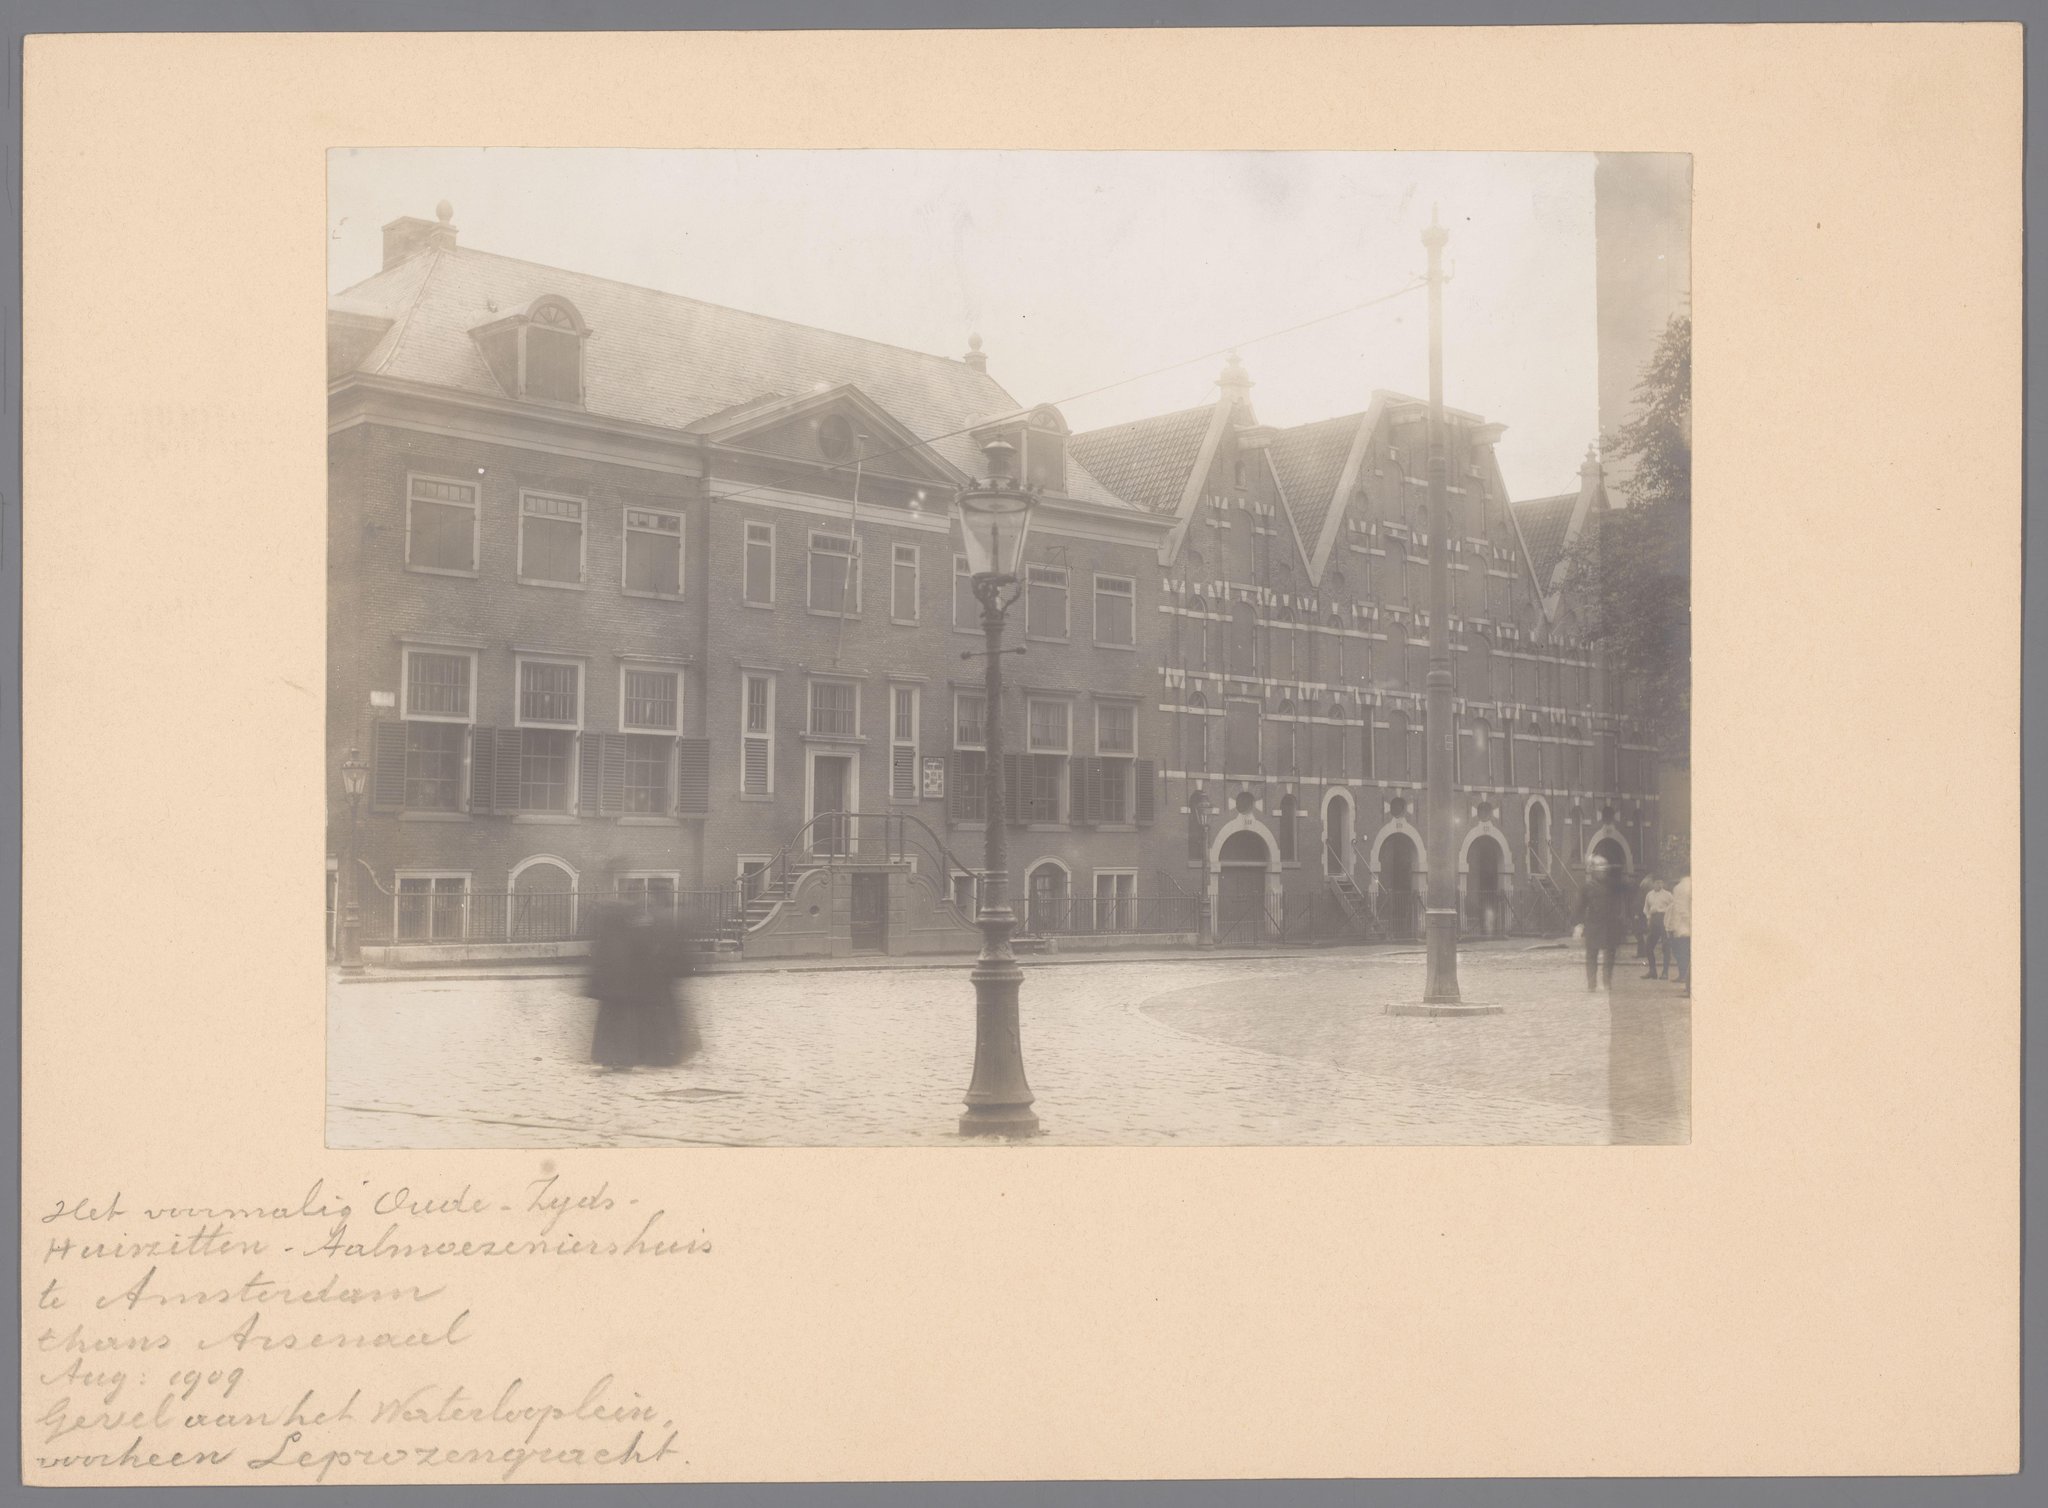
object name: photograph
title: Gezicht op het Arsenaal of de stadsturfpakhuizen te Amsterdam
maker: anoniem (monumentenzorg)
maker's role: fotograaf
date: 1909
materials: cardboard, photographic support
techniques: gelatin silver print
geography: waterlooplein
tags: large-scale structure for storage, e.g.: warehouse, depot, silo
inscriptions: annotation: ‘Het voormalig Oude-Zijds-Huiszitten-Aalmoezeniershuis te Amsterdam/ thans Arsenaal/ Aug: 1909/ Gevel aan het Waterlooplein, voorheen Leprozengracht’